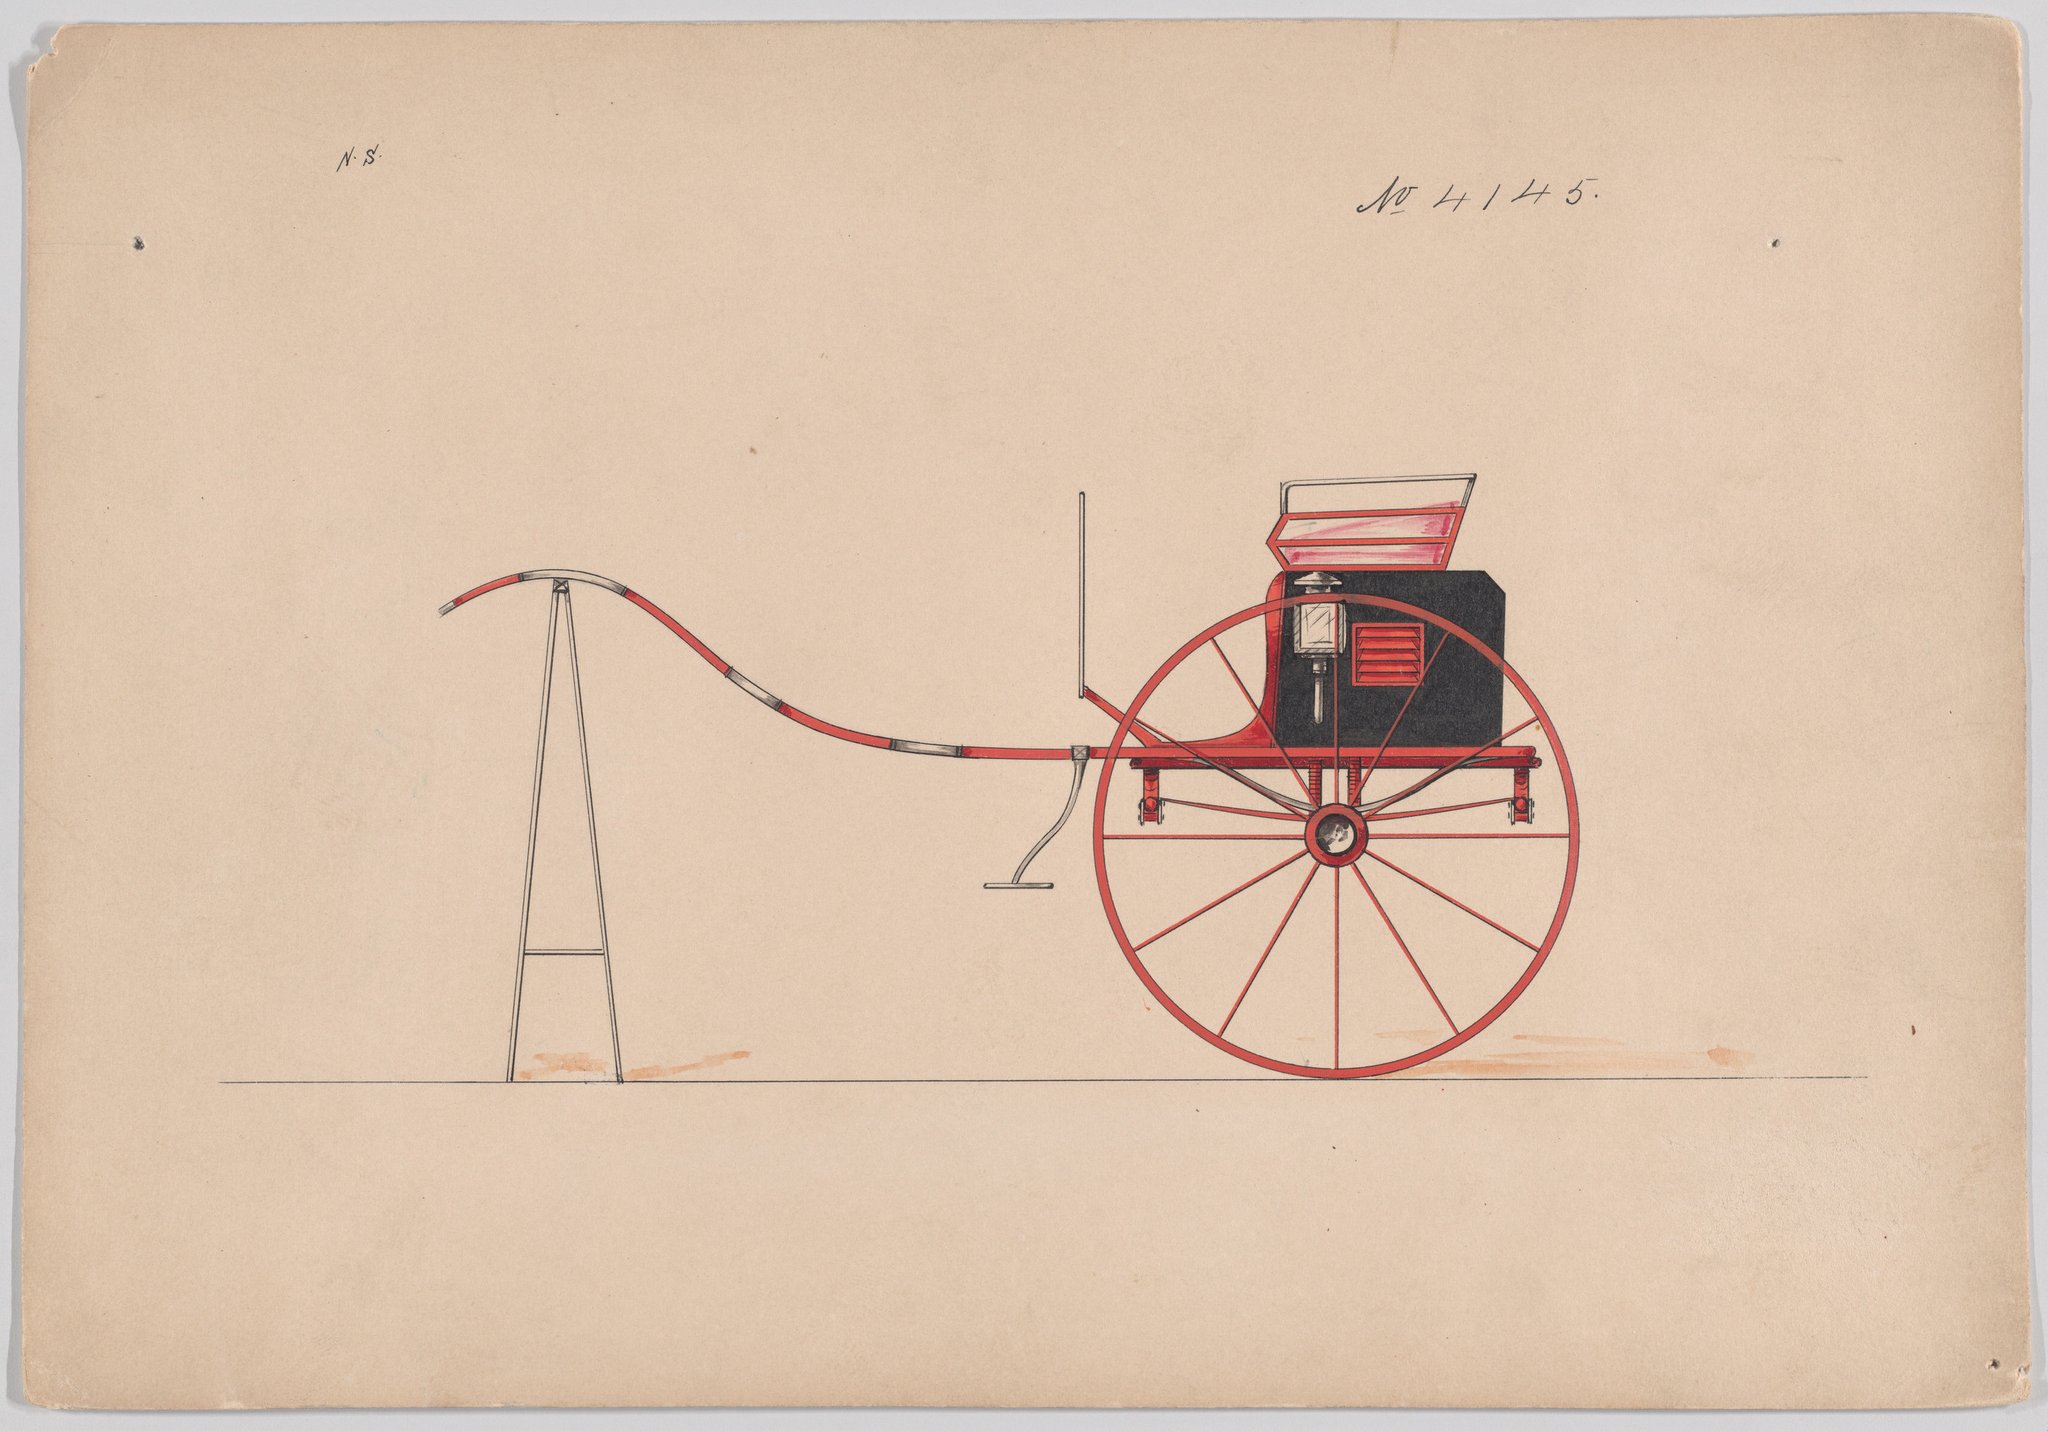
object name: drawing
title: Design for Dog Cart or 2 Wheeler, no. 4145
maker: brewster & co.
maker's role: manufacturer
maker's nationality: american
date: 1891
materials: gouache, ink, watercolor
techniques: pen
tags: carriages